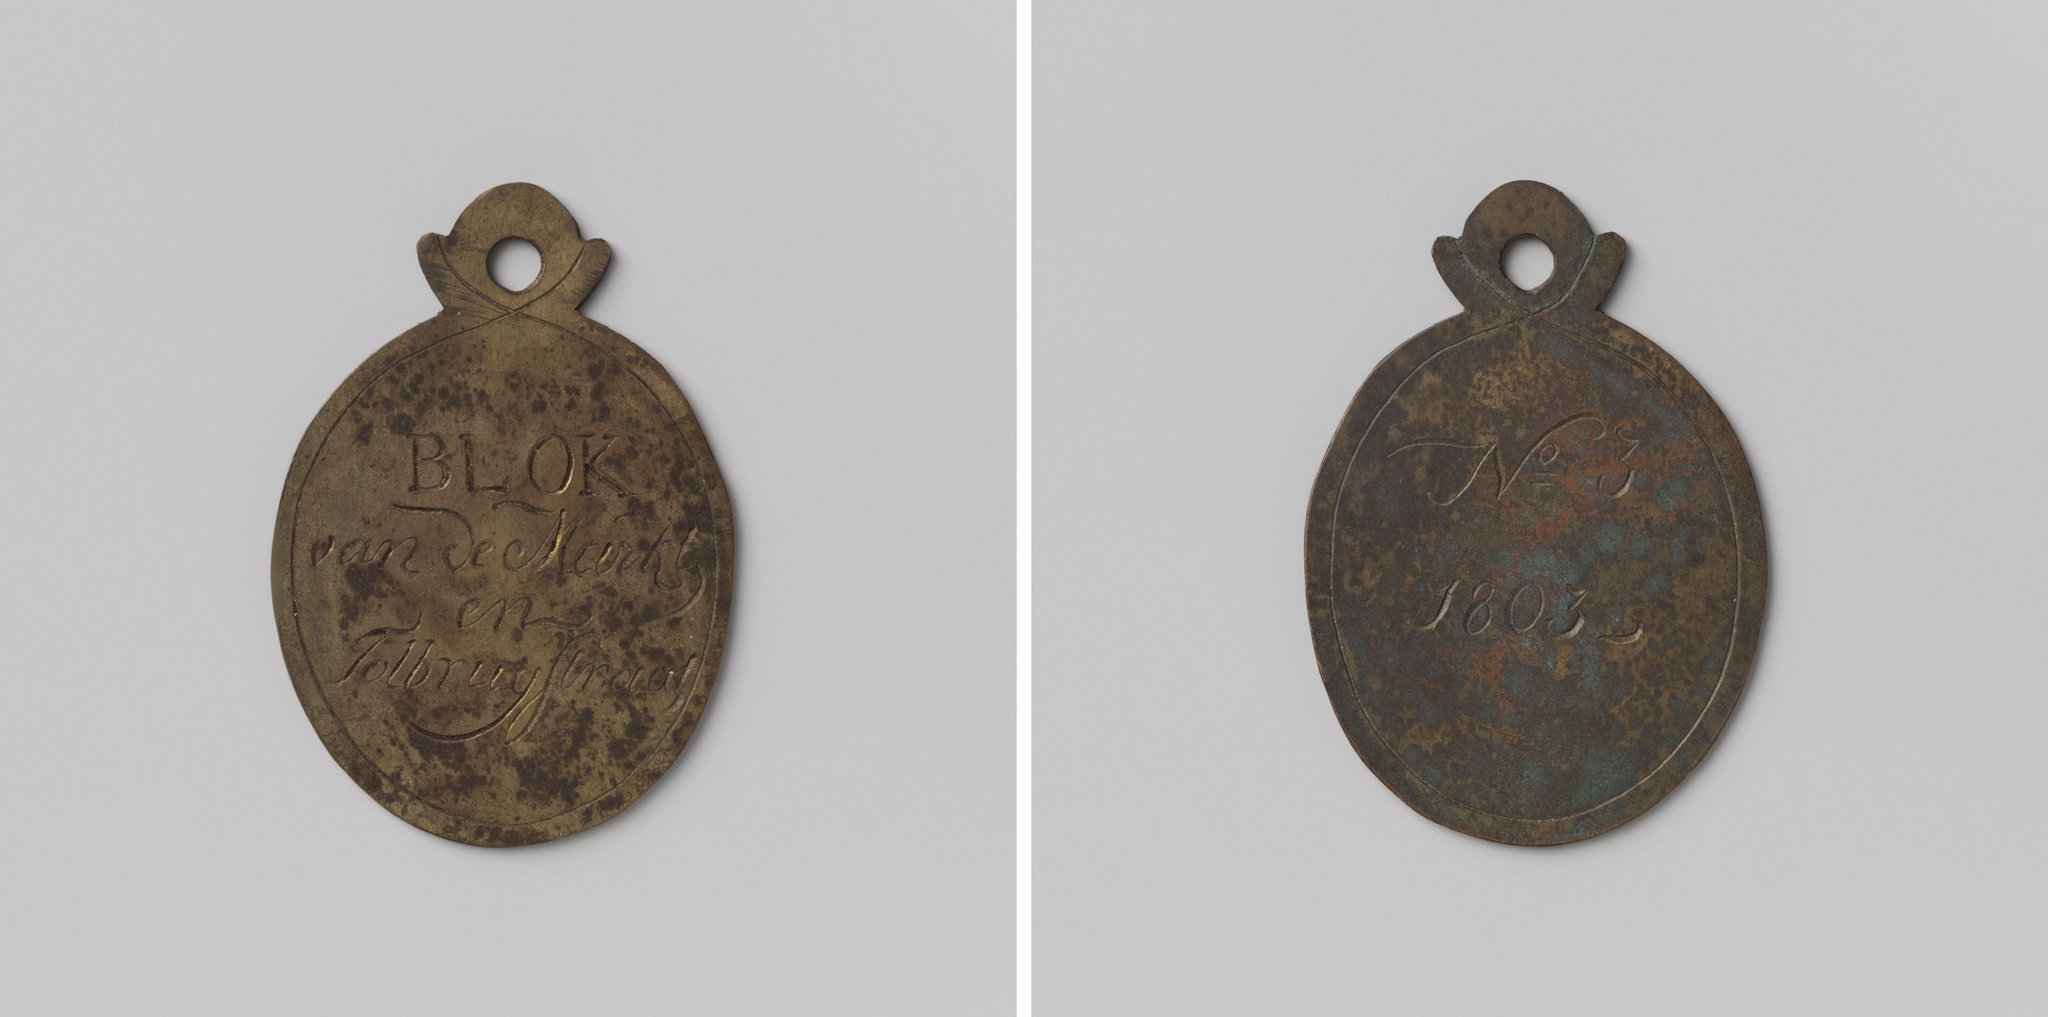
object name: identification medal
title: Armenpenning van het blok van de Markt en de Tolbrugstraat te 's-Hertogenbosch, penning met no. 3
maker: Anonymous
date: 1803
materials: brass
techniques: engraving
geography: den bosch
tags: markt (den bosch), tolbrugstraat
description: Messing penning aan draagoog. Voorzijde: opschrift. Keerzijde: opschrift